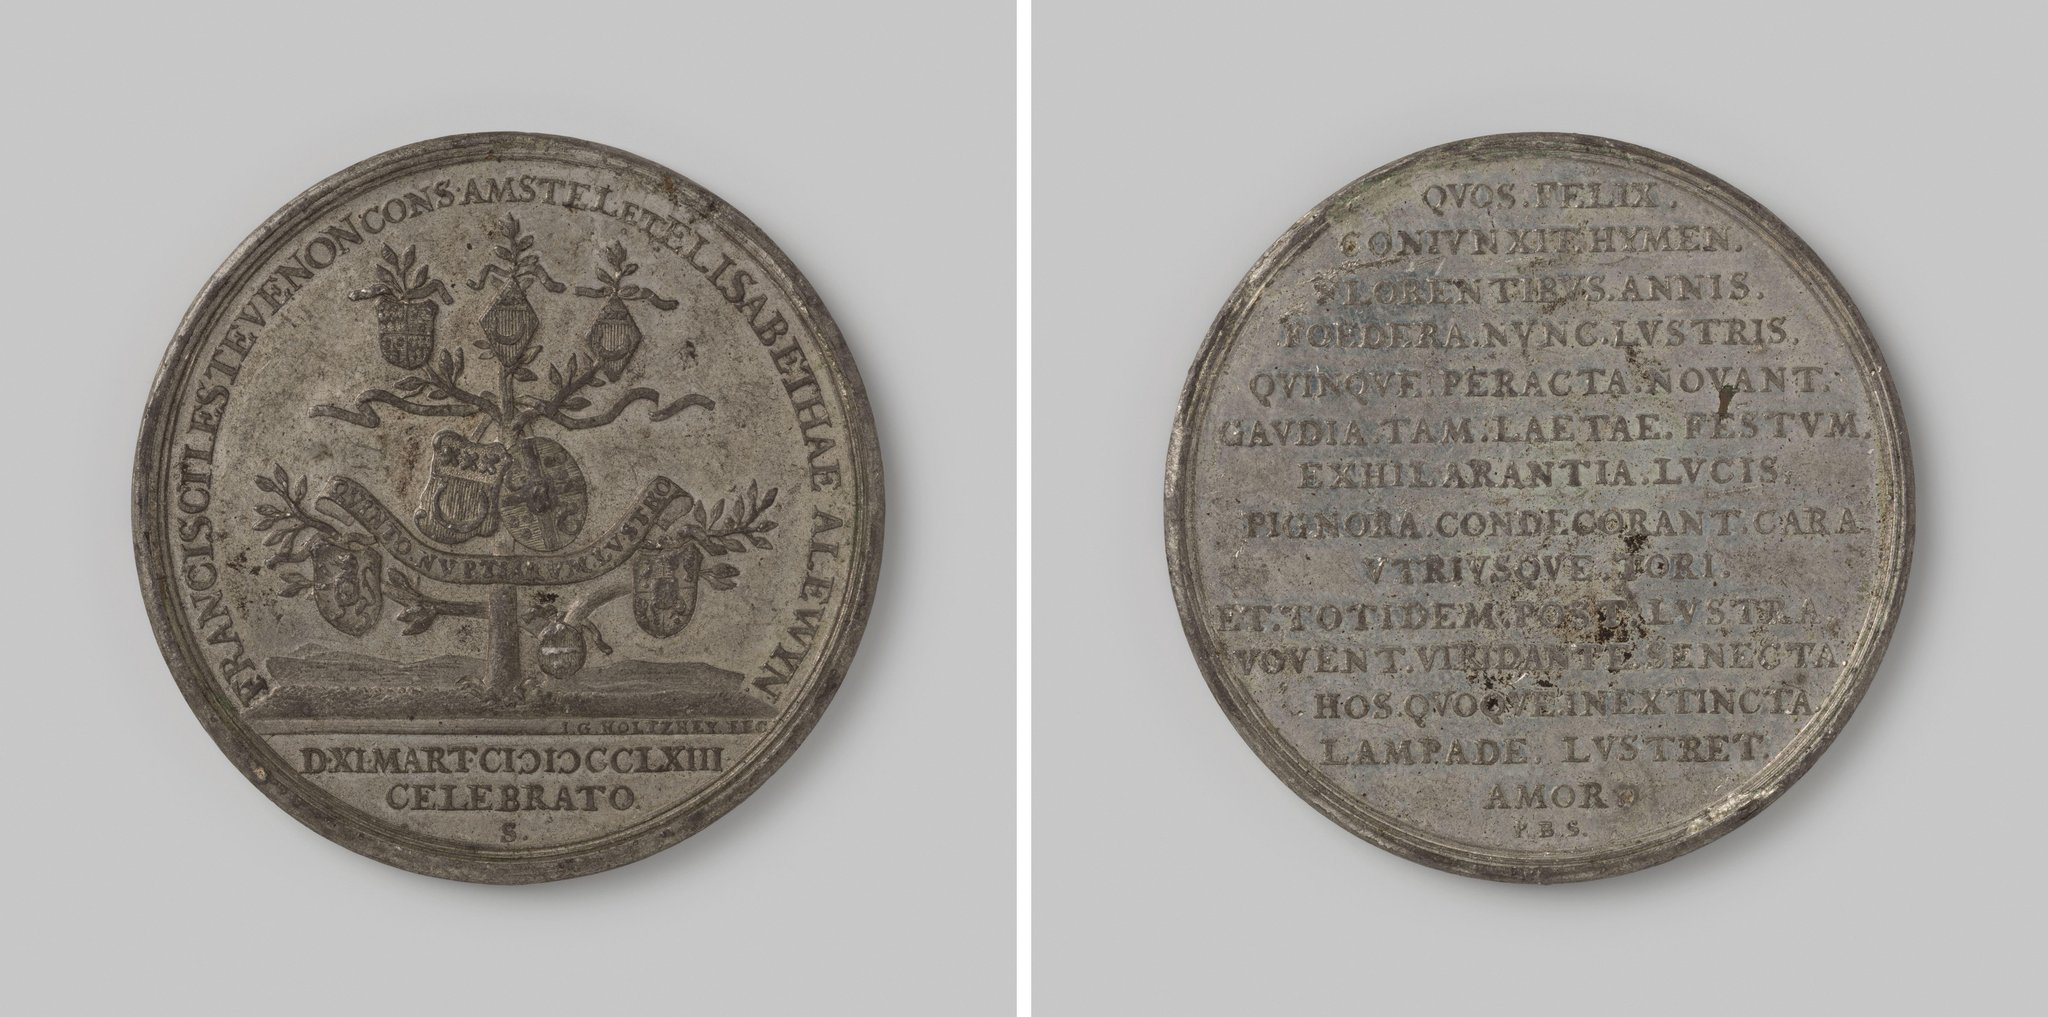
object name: family medal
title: Vijfentwintigjarig huwelijk van Franciscus Lestevenon en Elisabeth Alewijn 1763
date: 1763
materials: tin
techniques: striking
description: Tinnen penning, op de voorzijde in een landschap een boom met acht wapenschilden en een tekstlint, met omschrift en afsnedetekst, op de keerzijde veertien regels tekst.